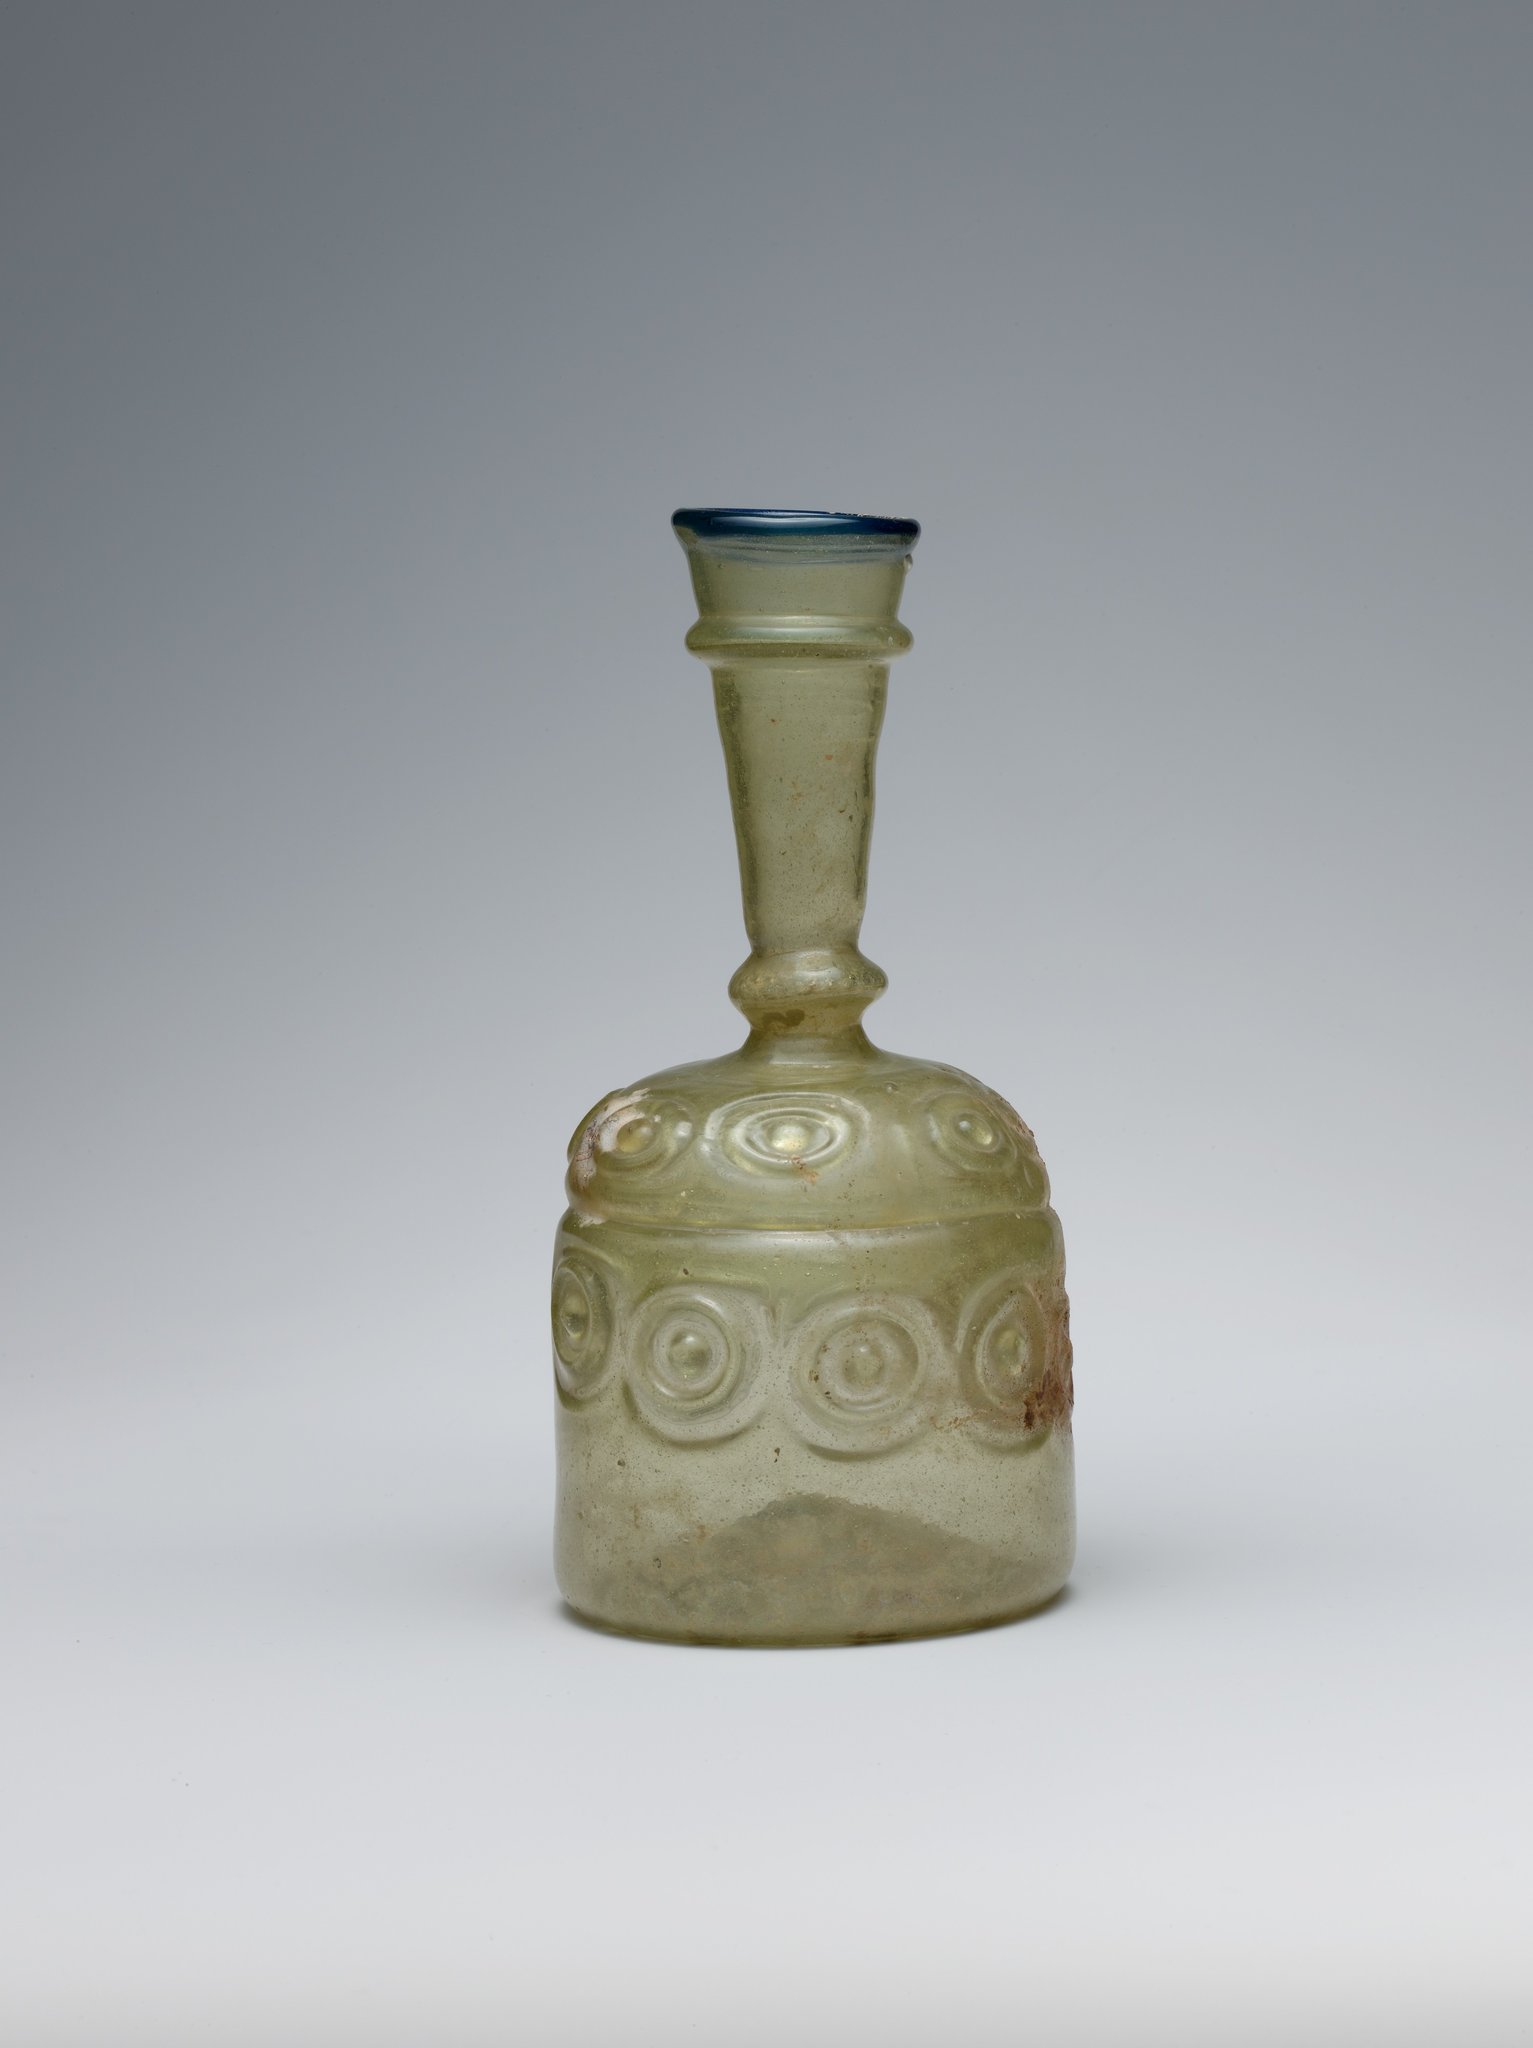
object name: bottle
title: Bottle with Impressed Decorations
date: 901-1100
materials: glass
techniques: glassblowing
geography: iran